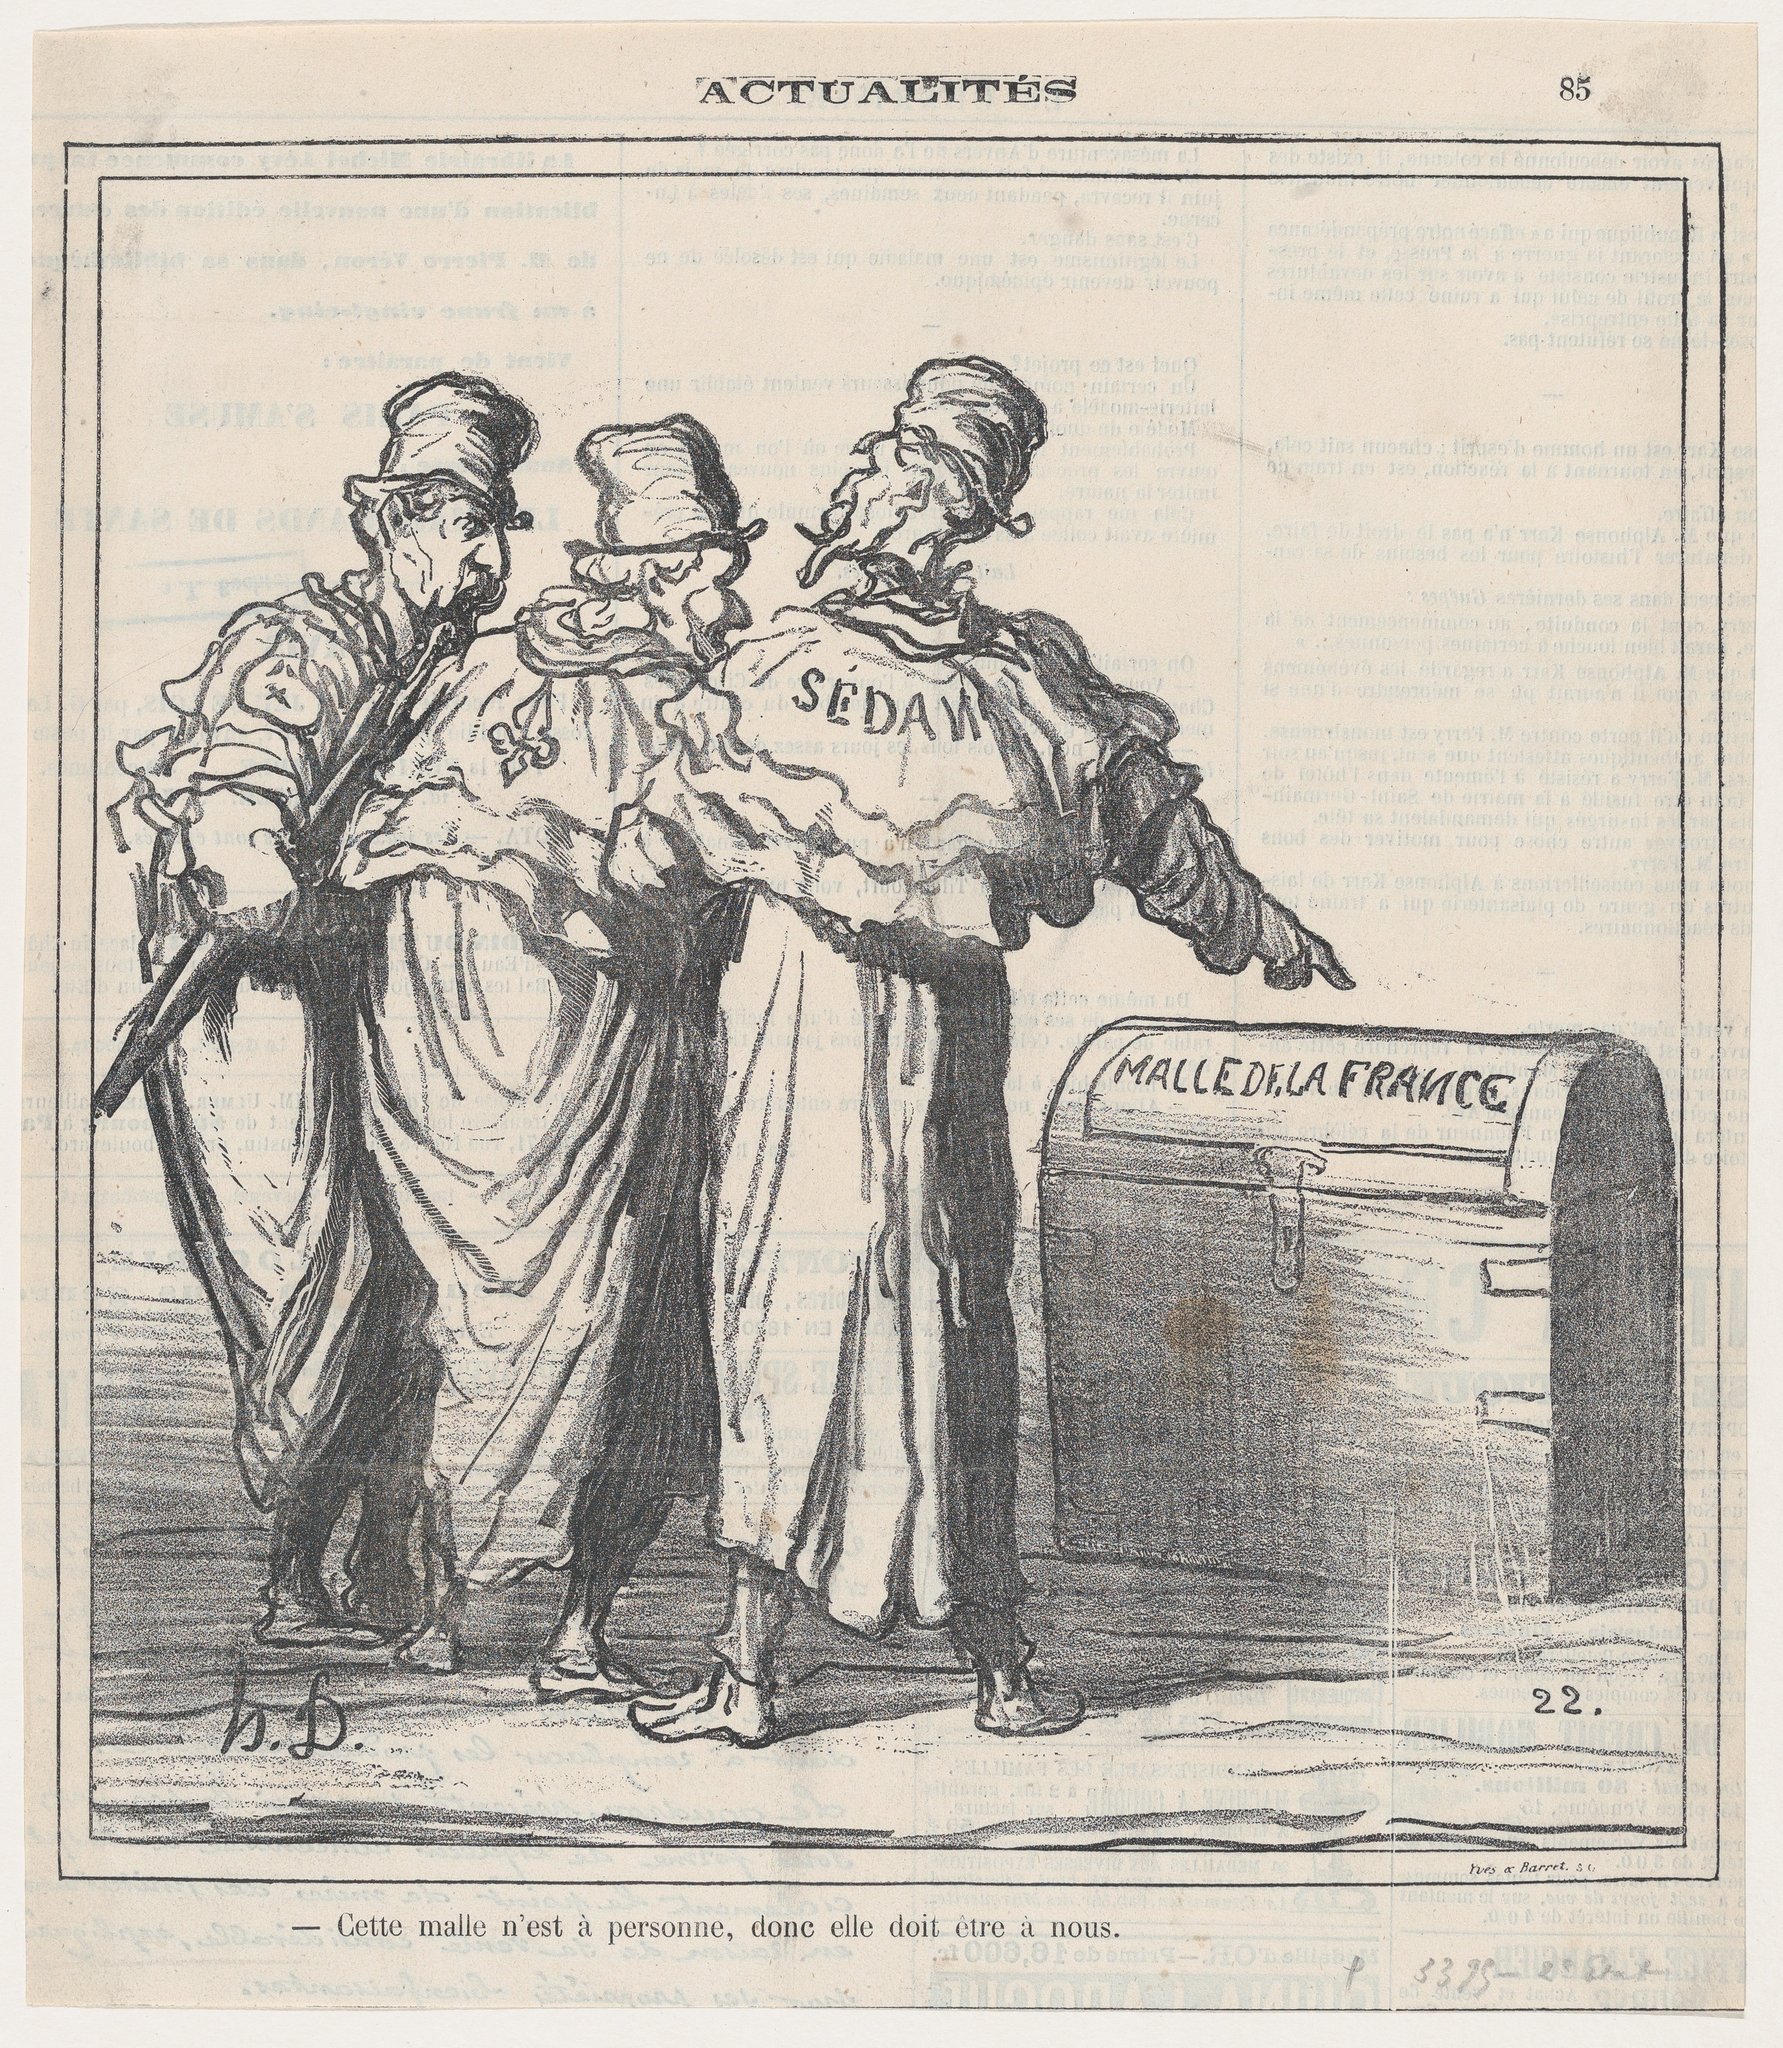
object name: print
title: This trunk belongs no one, so it must be ours!, from 'News of the day,' published in "Le Charivari"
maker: honoré daumier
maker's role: artist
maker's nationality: french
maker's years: 1808-1879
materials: paper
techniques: lithograph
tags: satire,men